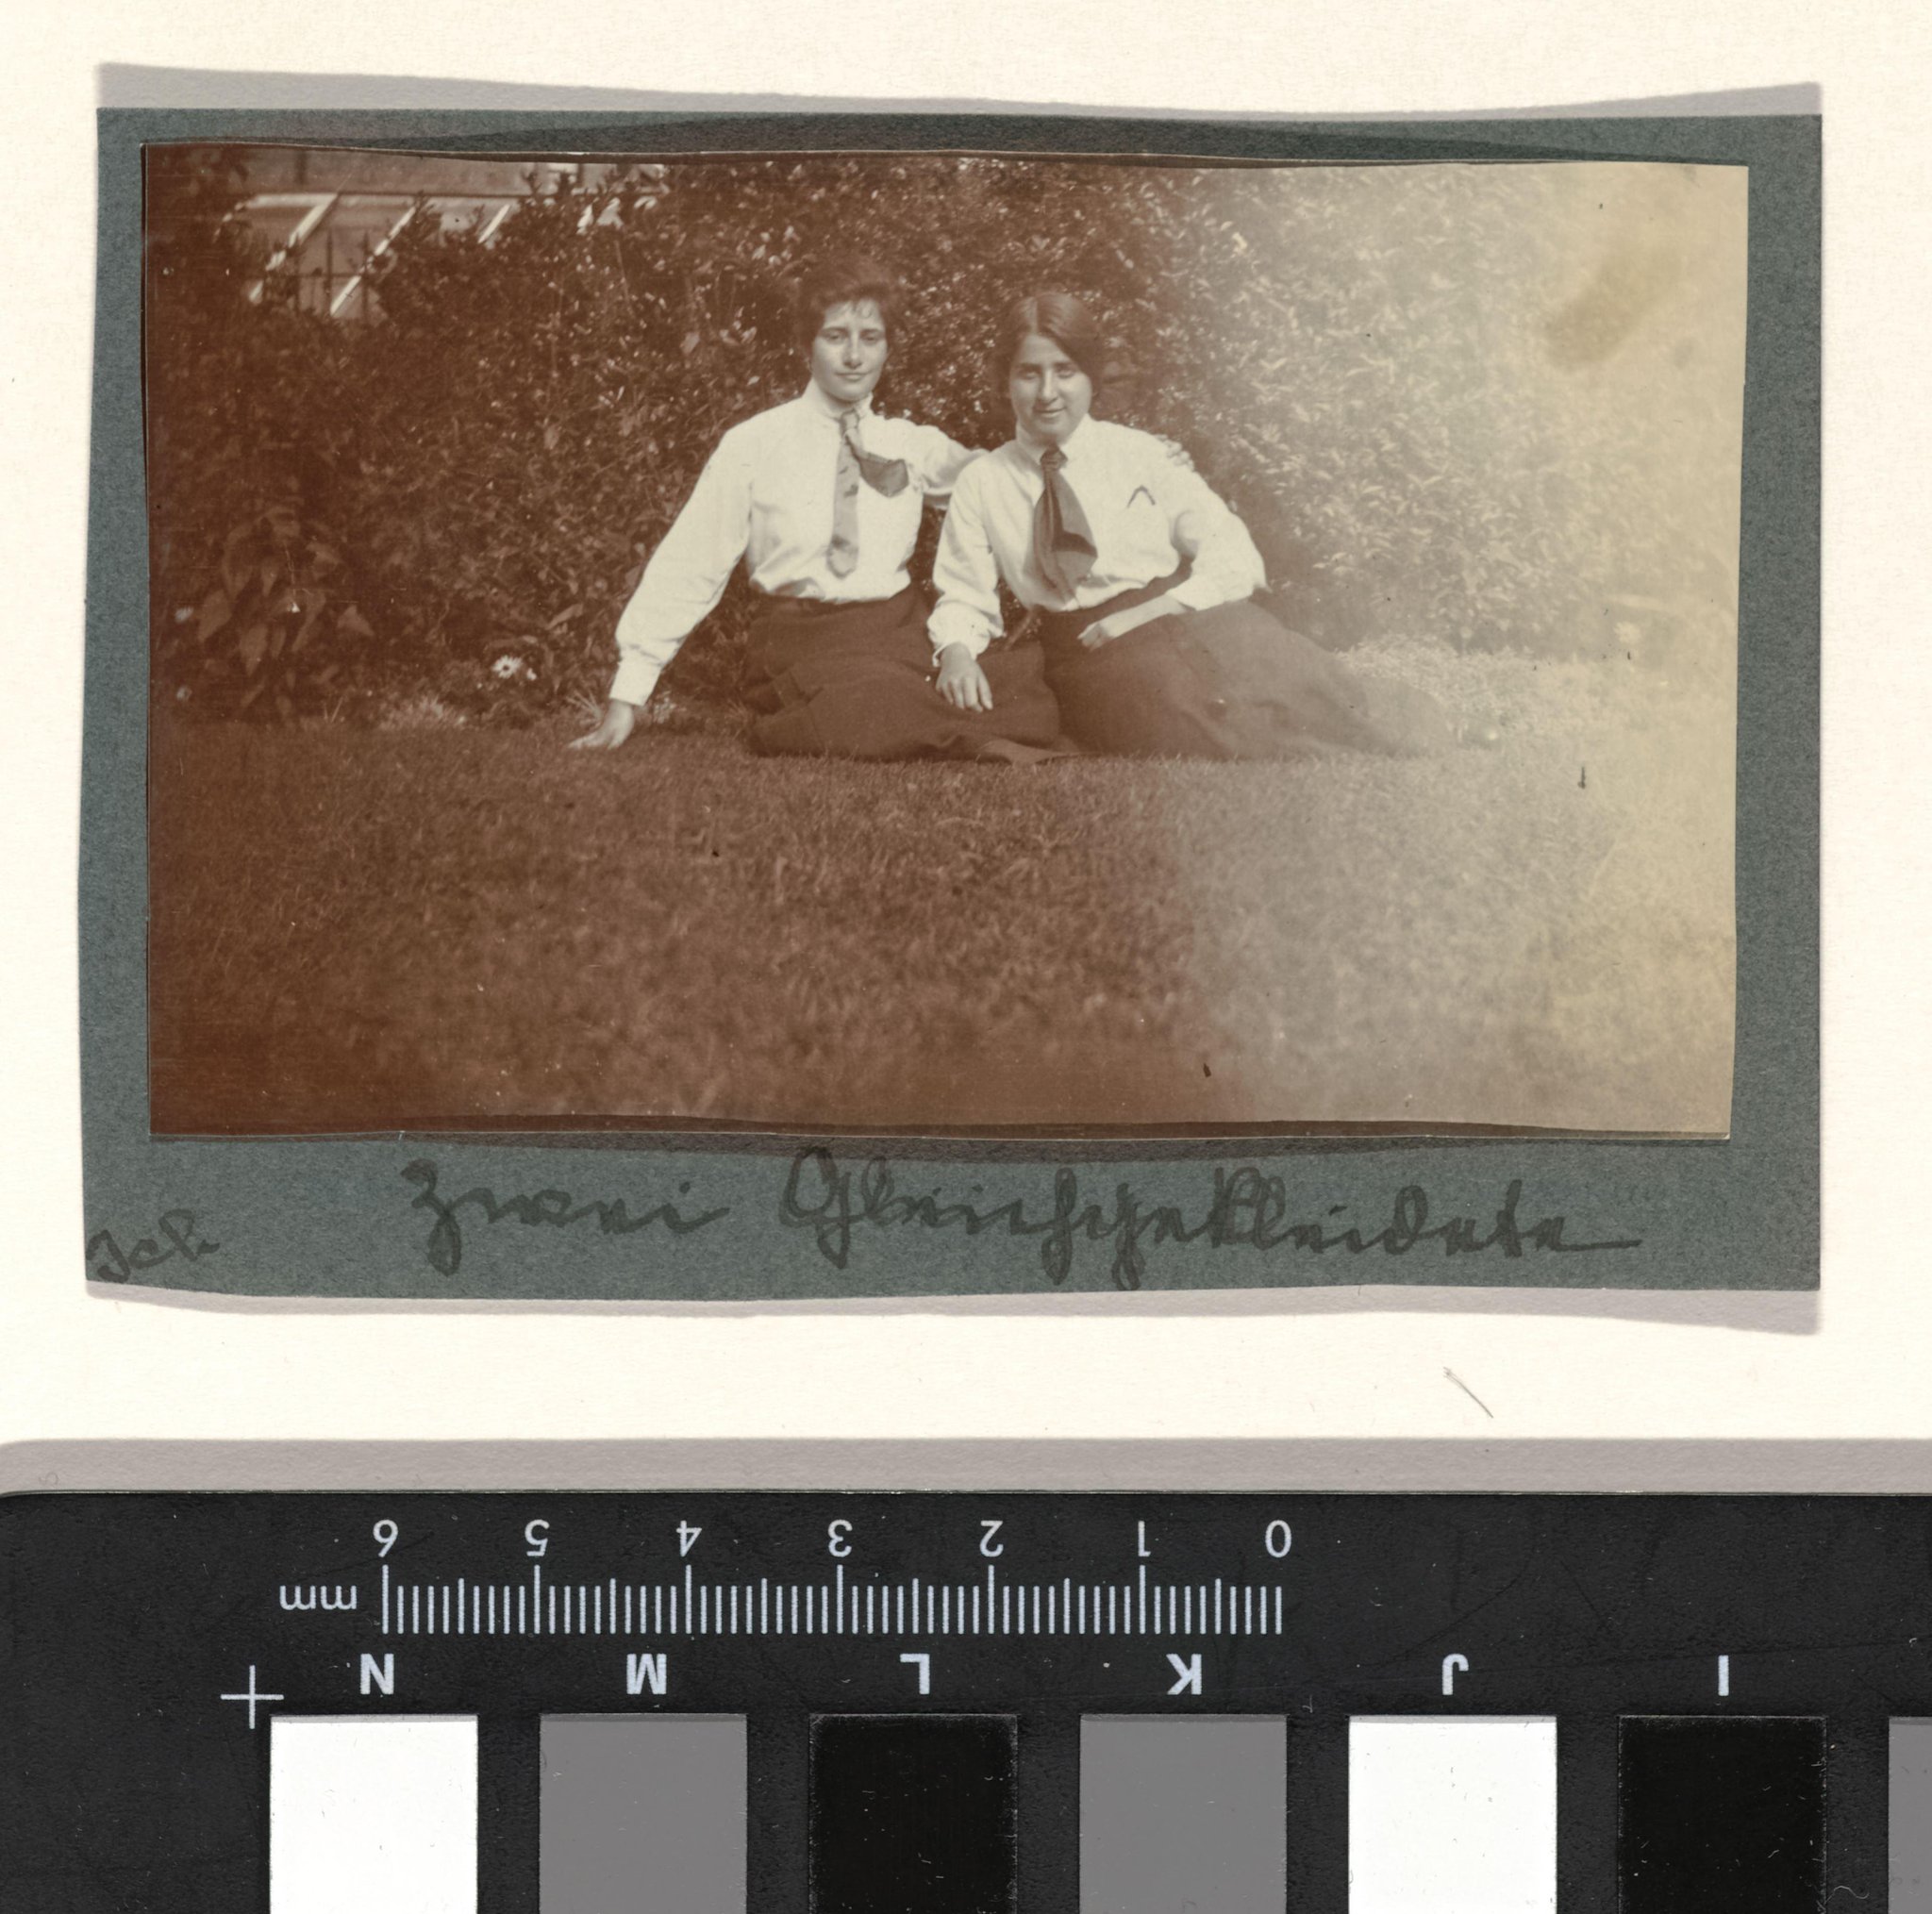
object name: photograph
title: Else Wachenheimer-Moos voor een onbekend gebouw in het schooluniform van de huishoudschool in Bexhill-on-Sea, Engeland, 1913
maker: Anonymous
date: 1913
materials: photographic support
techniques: gelatin silver print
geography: bexhill-on-sea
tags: else wachenheimer-moos, england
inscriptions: inscription: ‘Seh ich nicht wie ein Frechdachs aus?!’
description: Else Wachenheimer-Moos voor een onbekend gebouw in het schooluniform van de huishoudschool in Bexhill-on-Sea, Engeland.